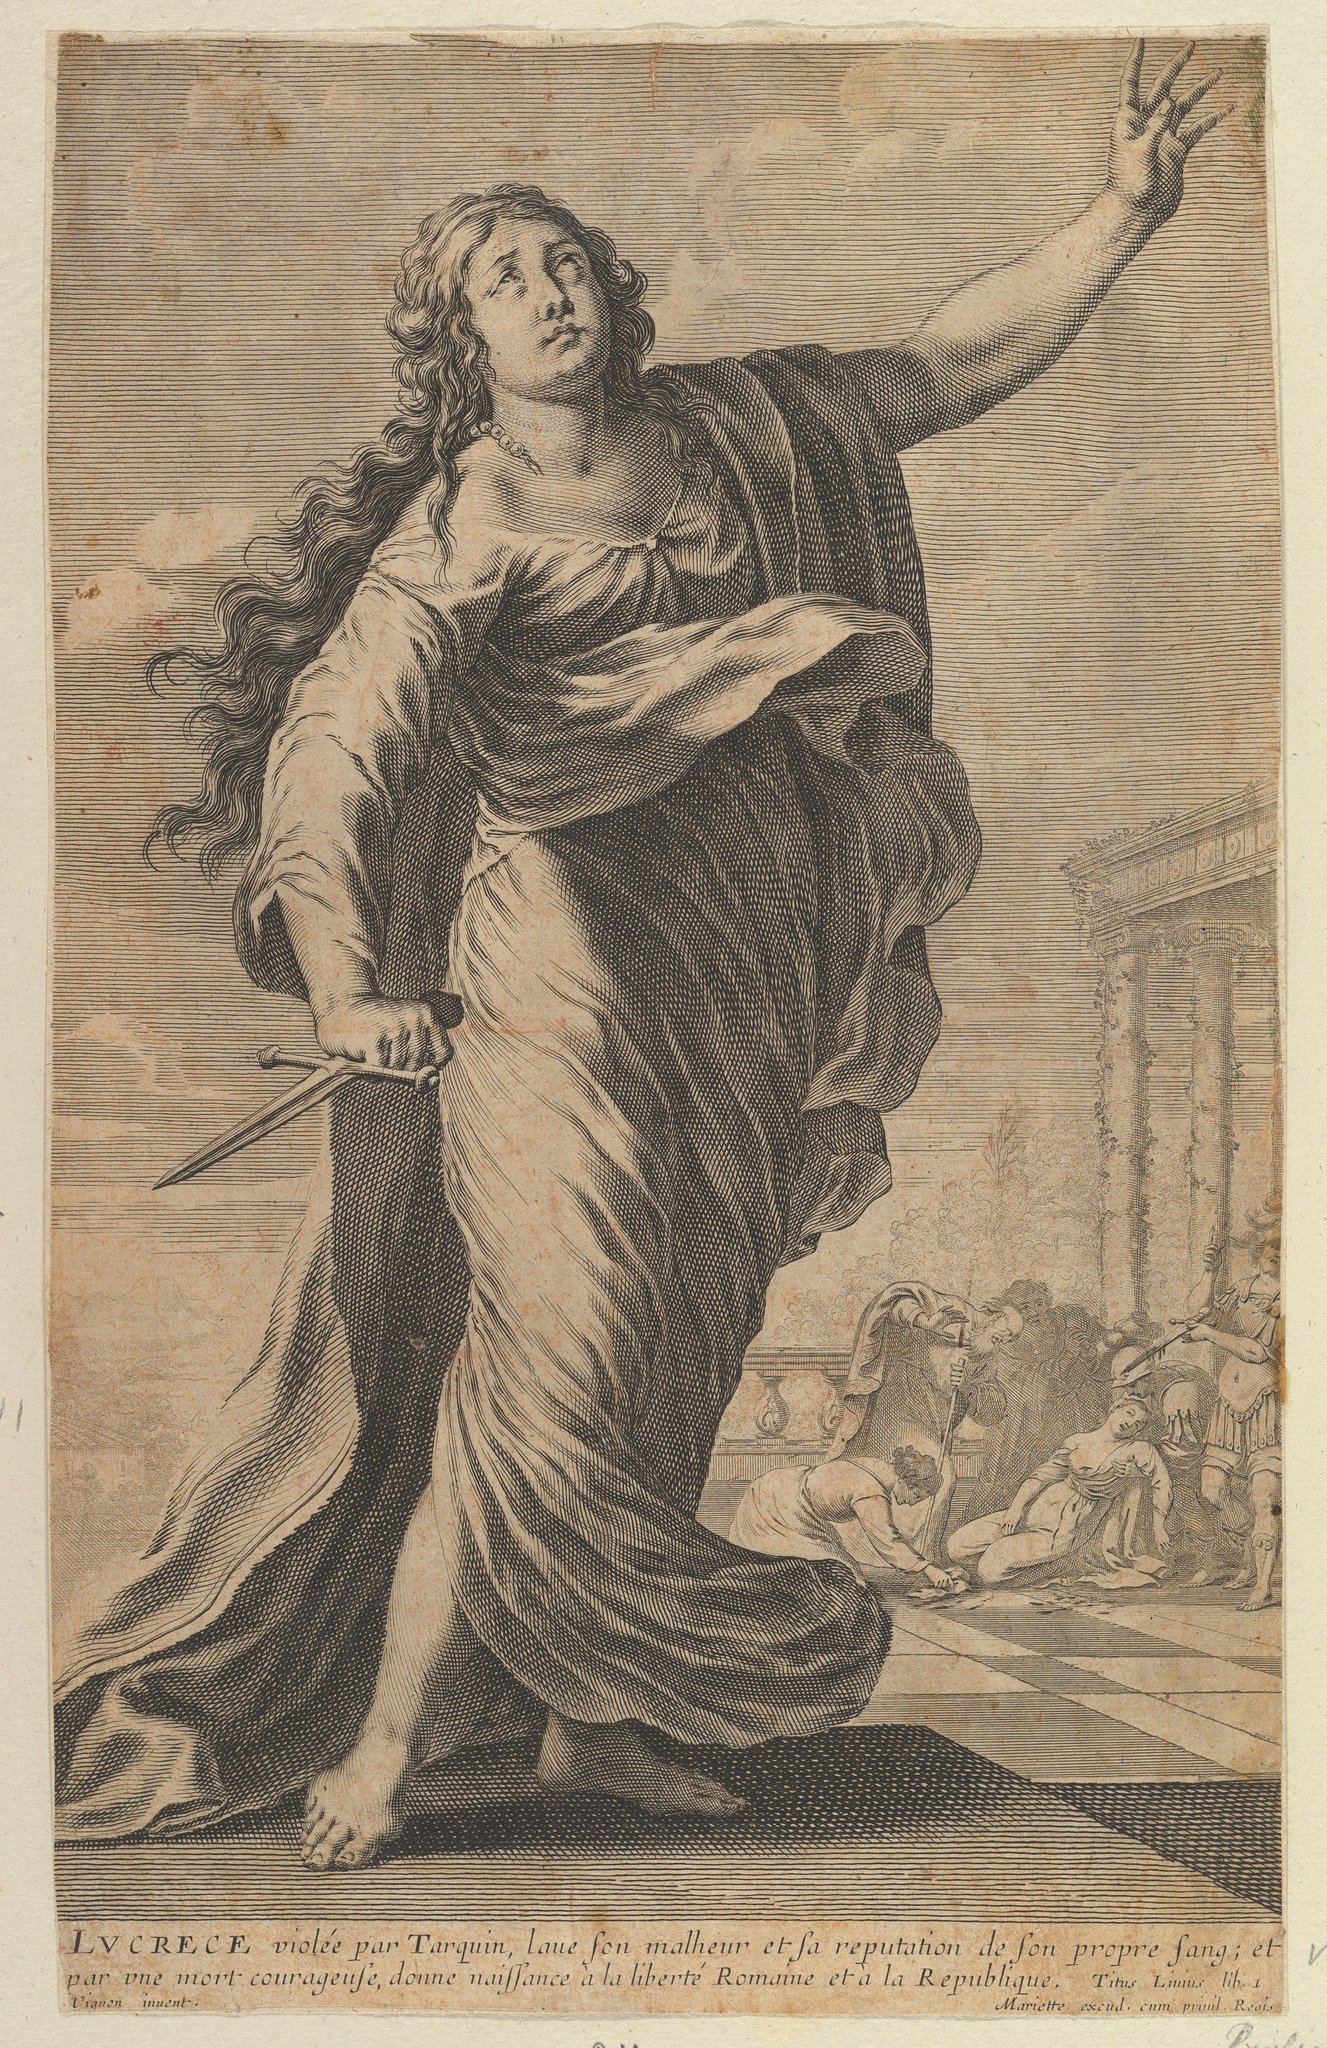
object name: print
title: Lucrèce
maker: gilles rousselet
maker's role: artist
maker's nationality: french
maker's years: 1614-1686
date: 1647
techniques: engraving, etching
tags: daggers,women